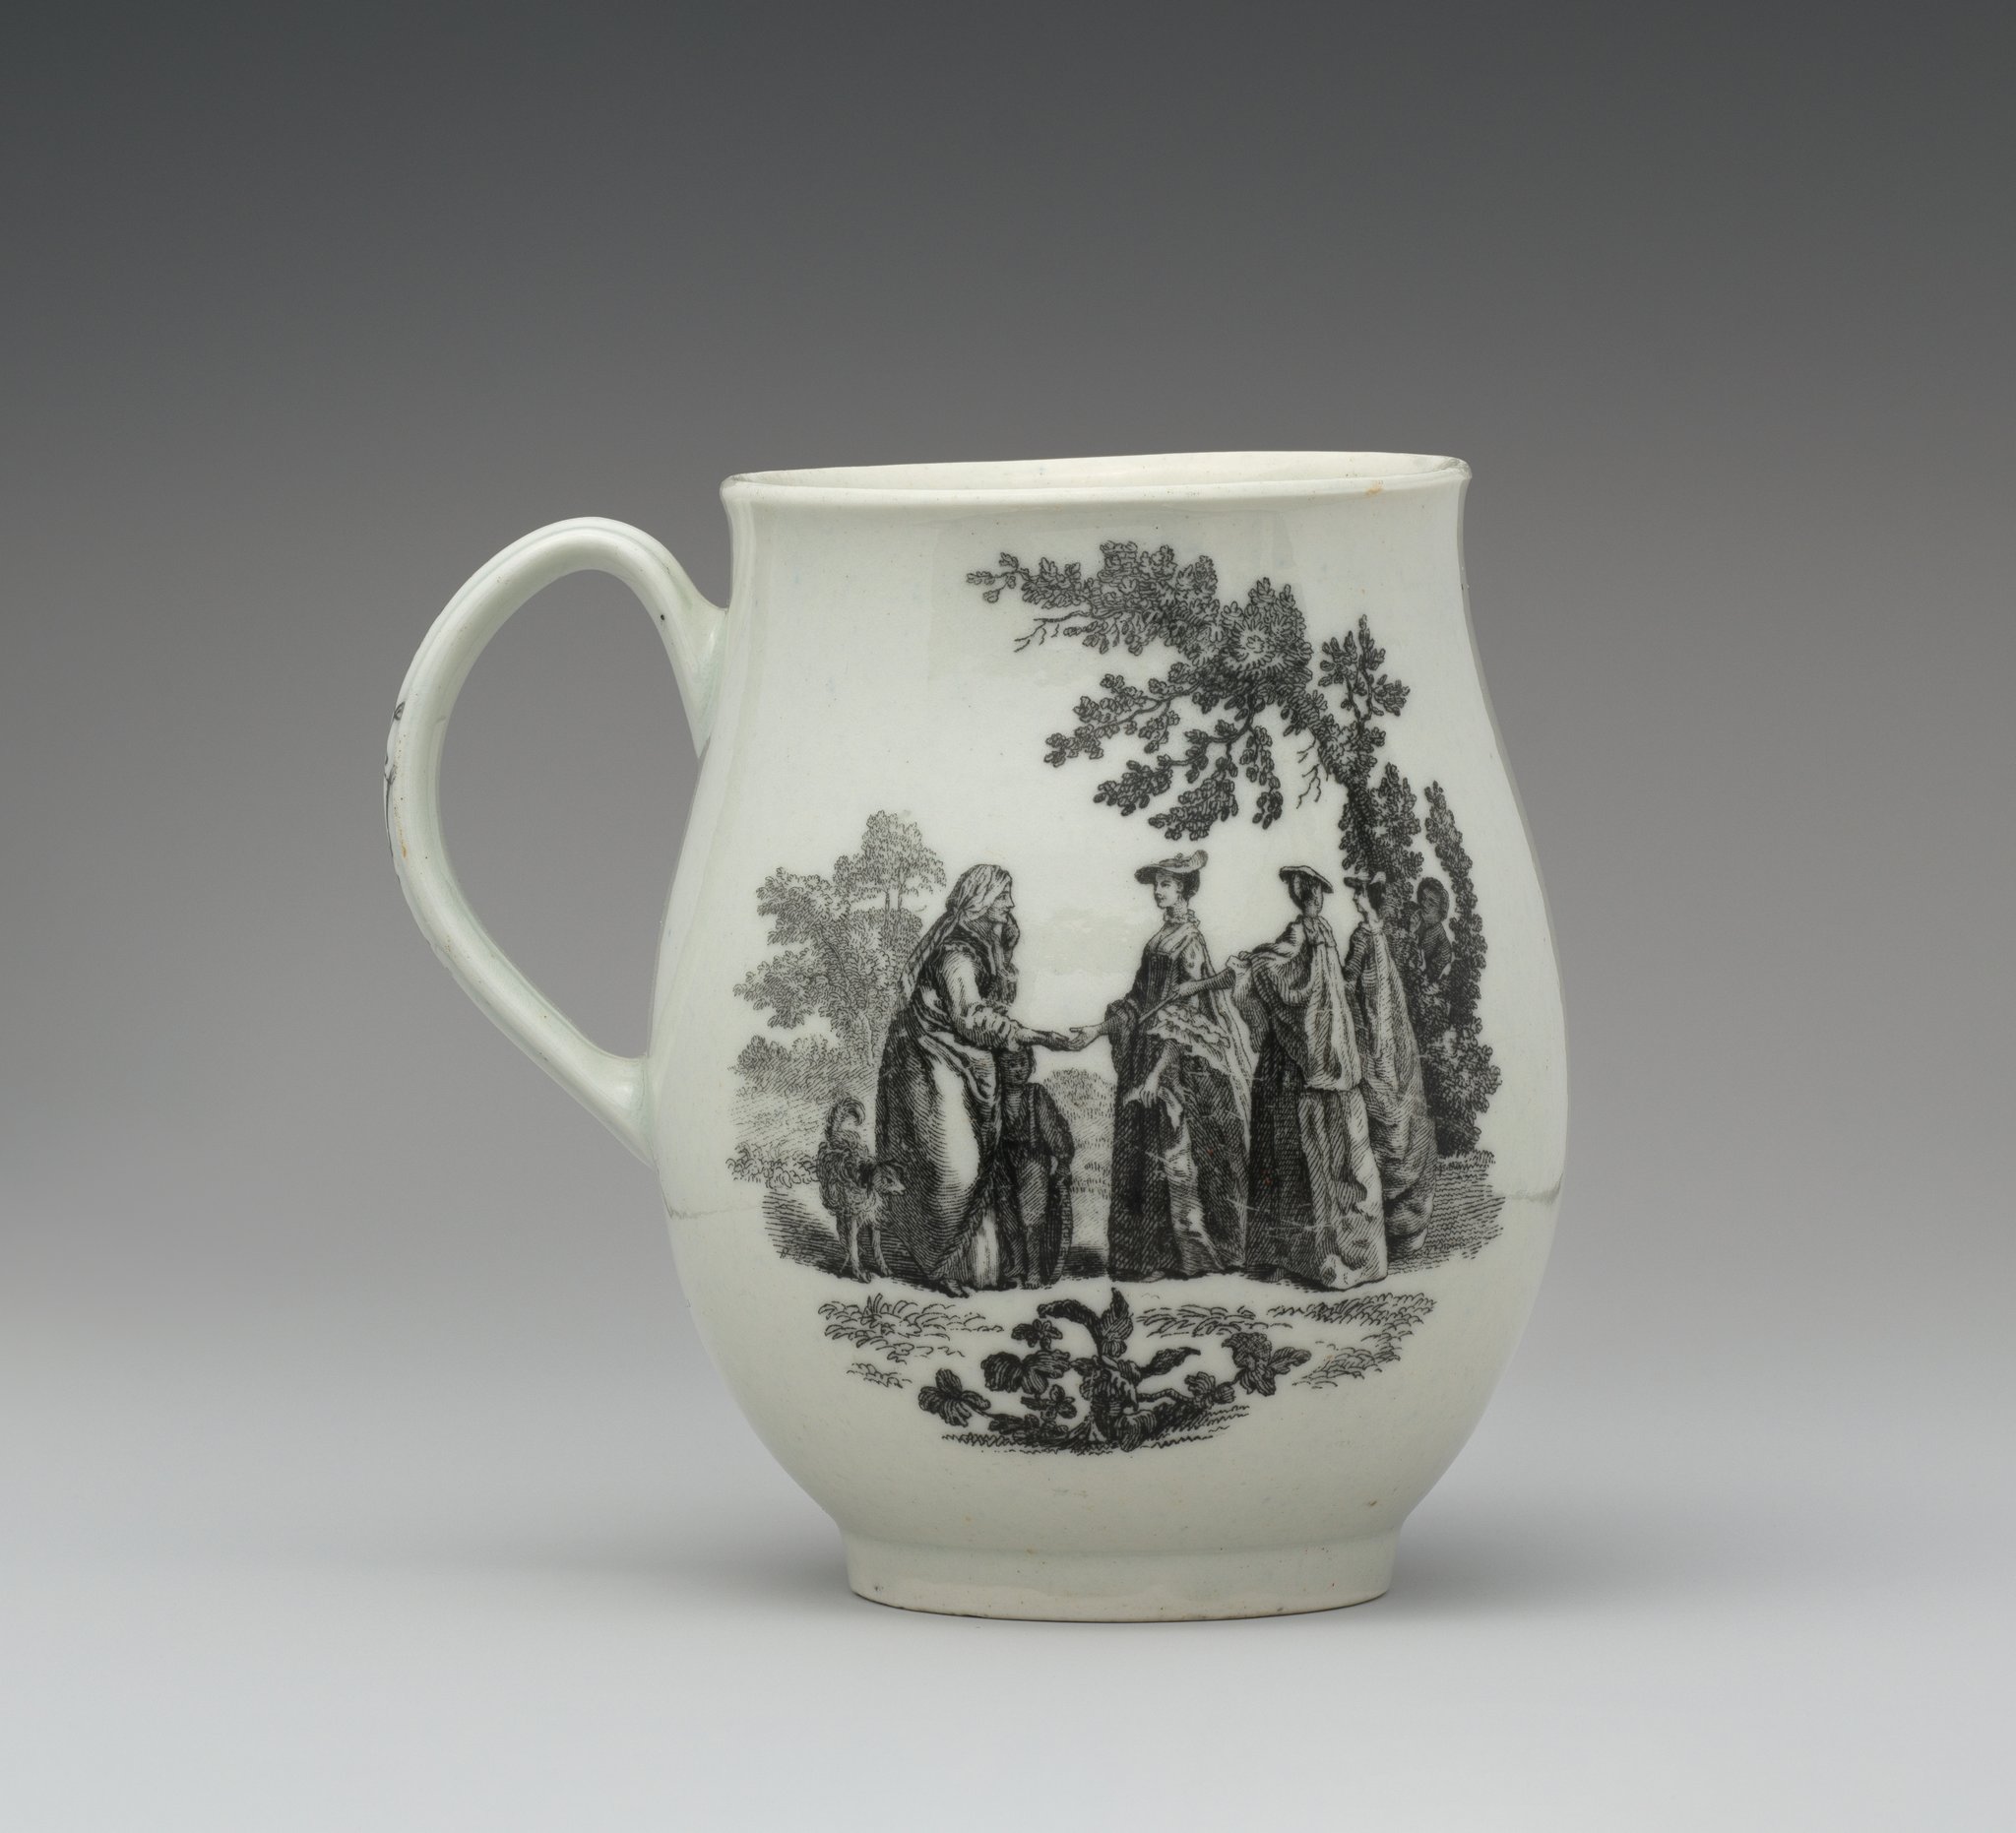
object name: mug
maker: worcester factory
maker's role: manufactory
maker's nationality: british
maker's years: 1751-2008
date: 1765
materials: soft paste porcelain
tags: men,women,fishing,dogs,trees,baskets